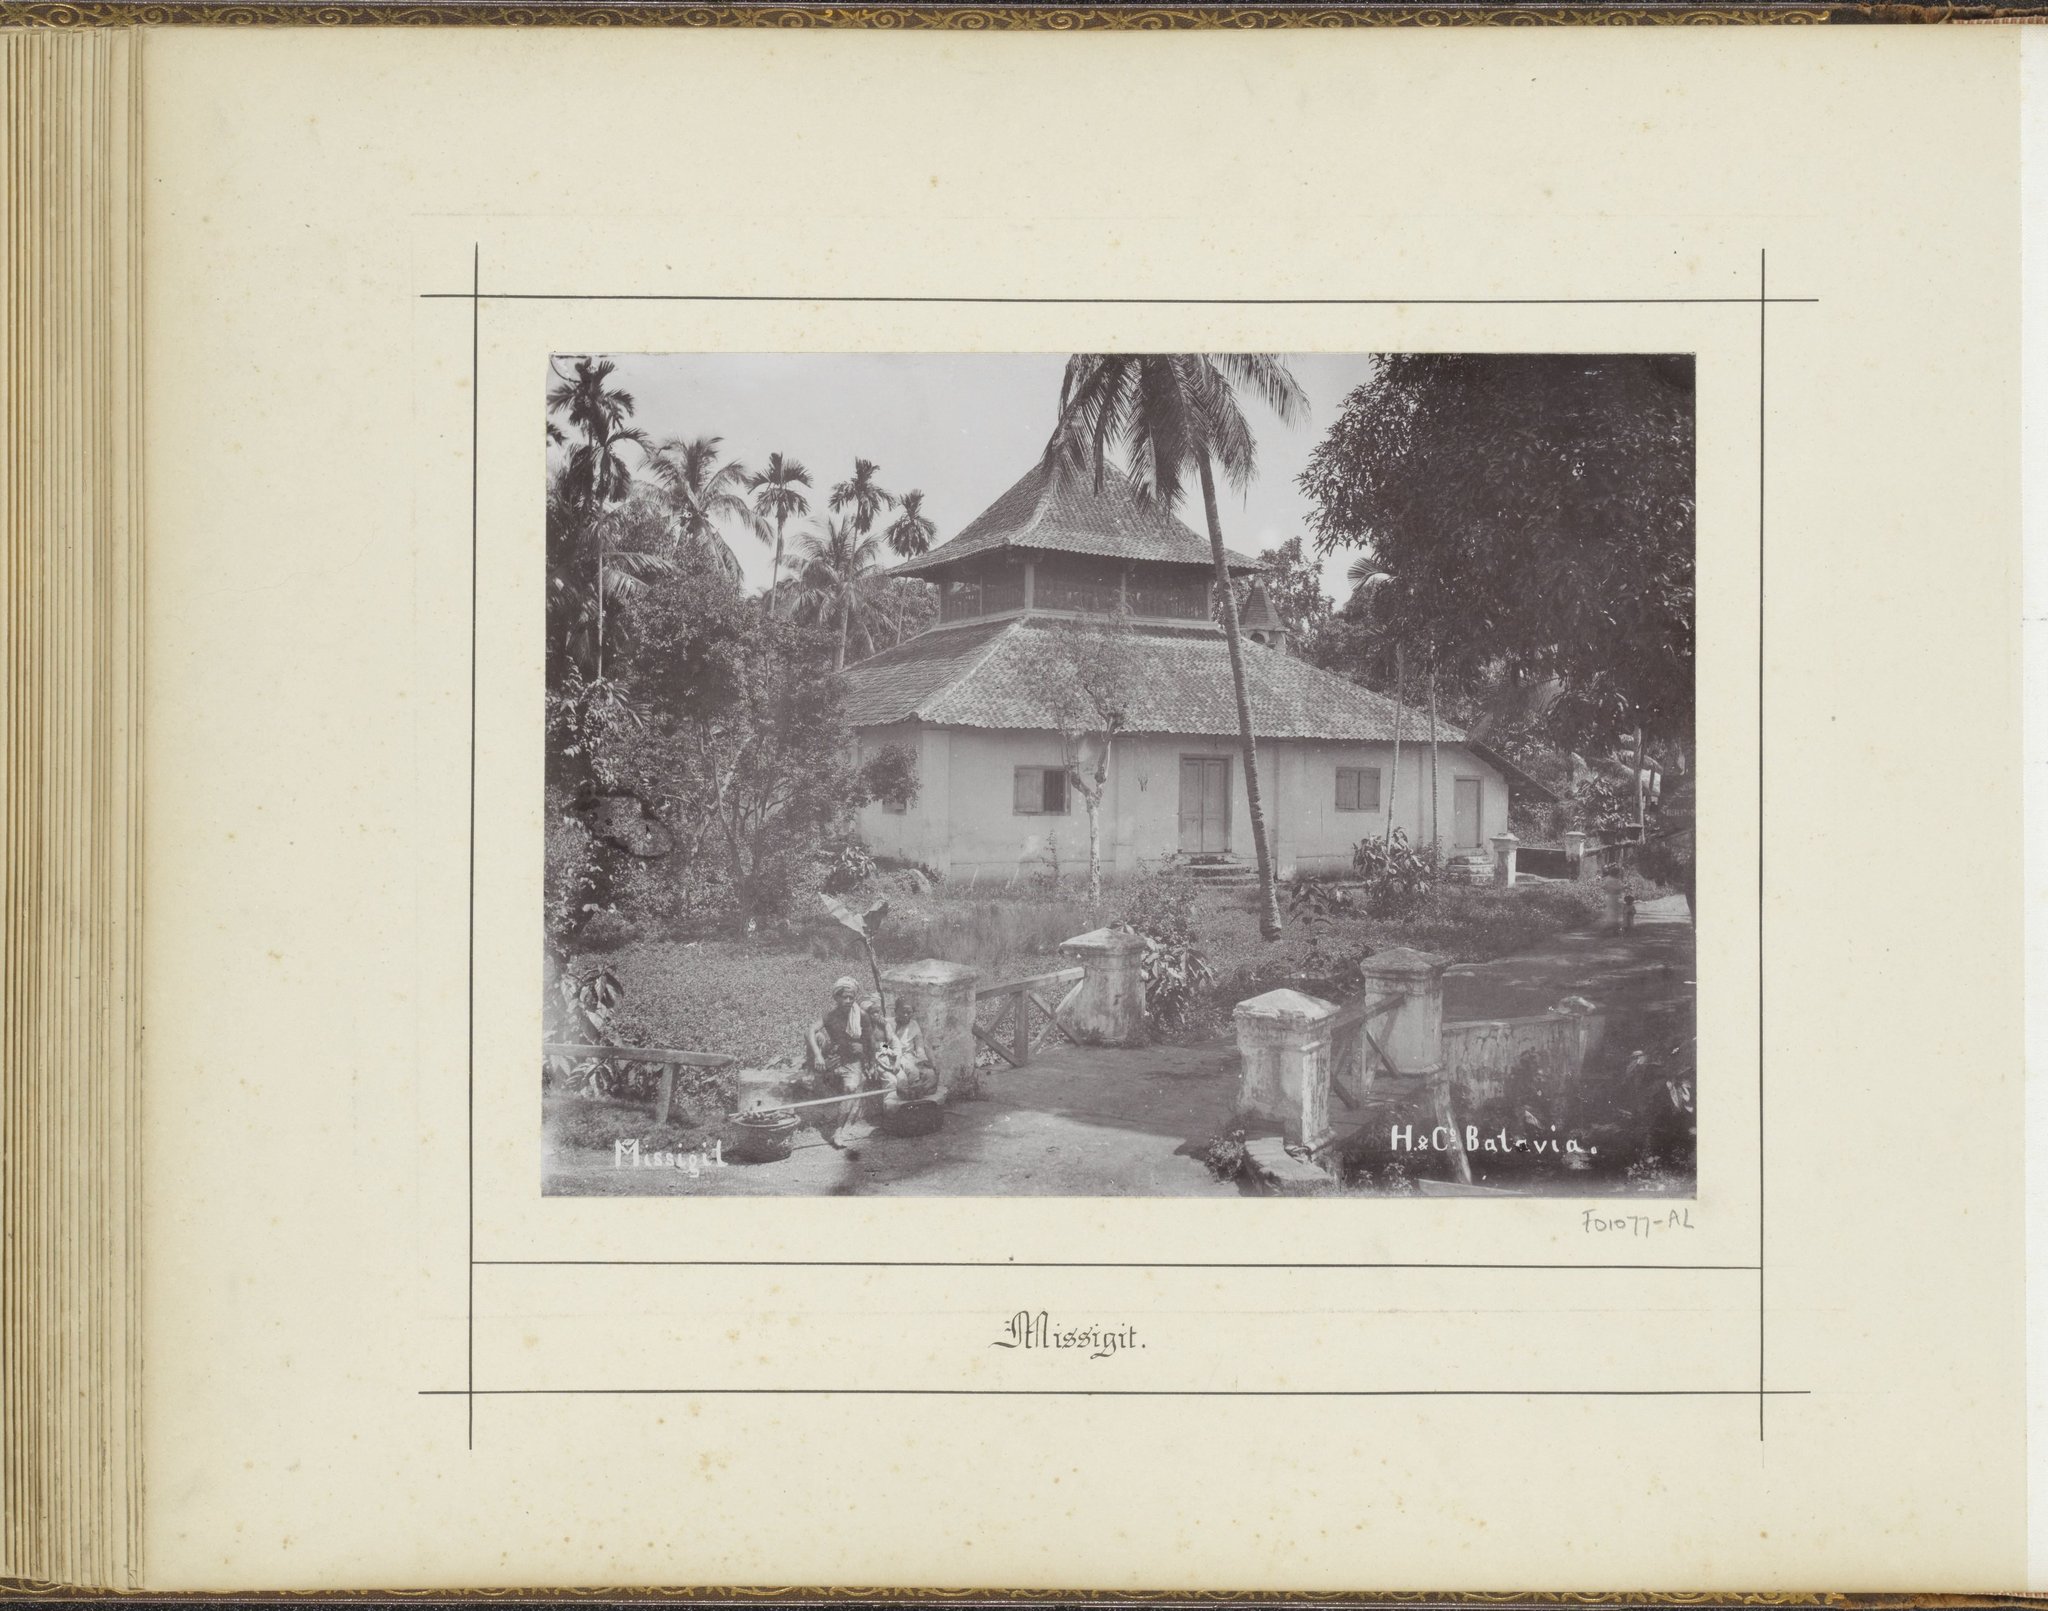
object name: photograph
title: Moskee in Batavia met op de voorgrond een Indische man met twee kinderen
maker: otto hisgen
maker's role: fotograaf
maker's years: 1874-1944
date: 1890-1910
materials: cardboard, photographic support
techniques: collodion silver print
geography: batavia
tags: temple, shrine ~ islam, mohammedanism, batavia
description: Onderdeel van Album met foto's van Batavia en van de zusters Ursulinen.